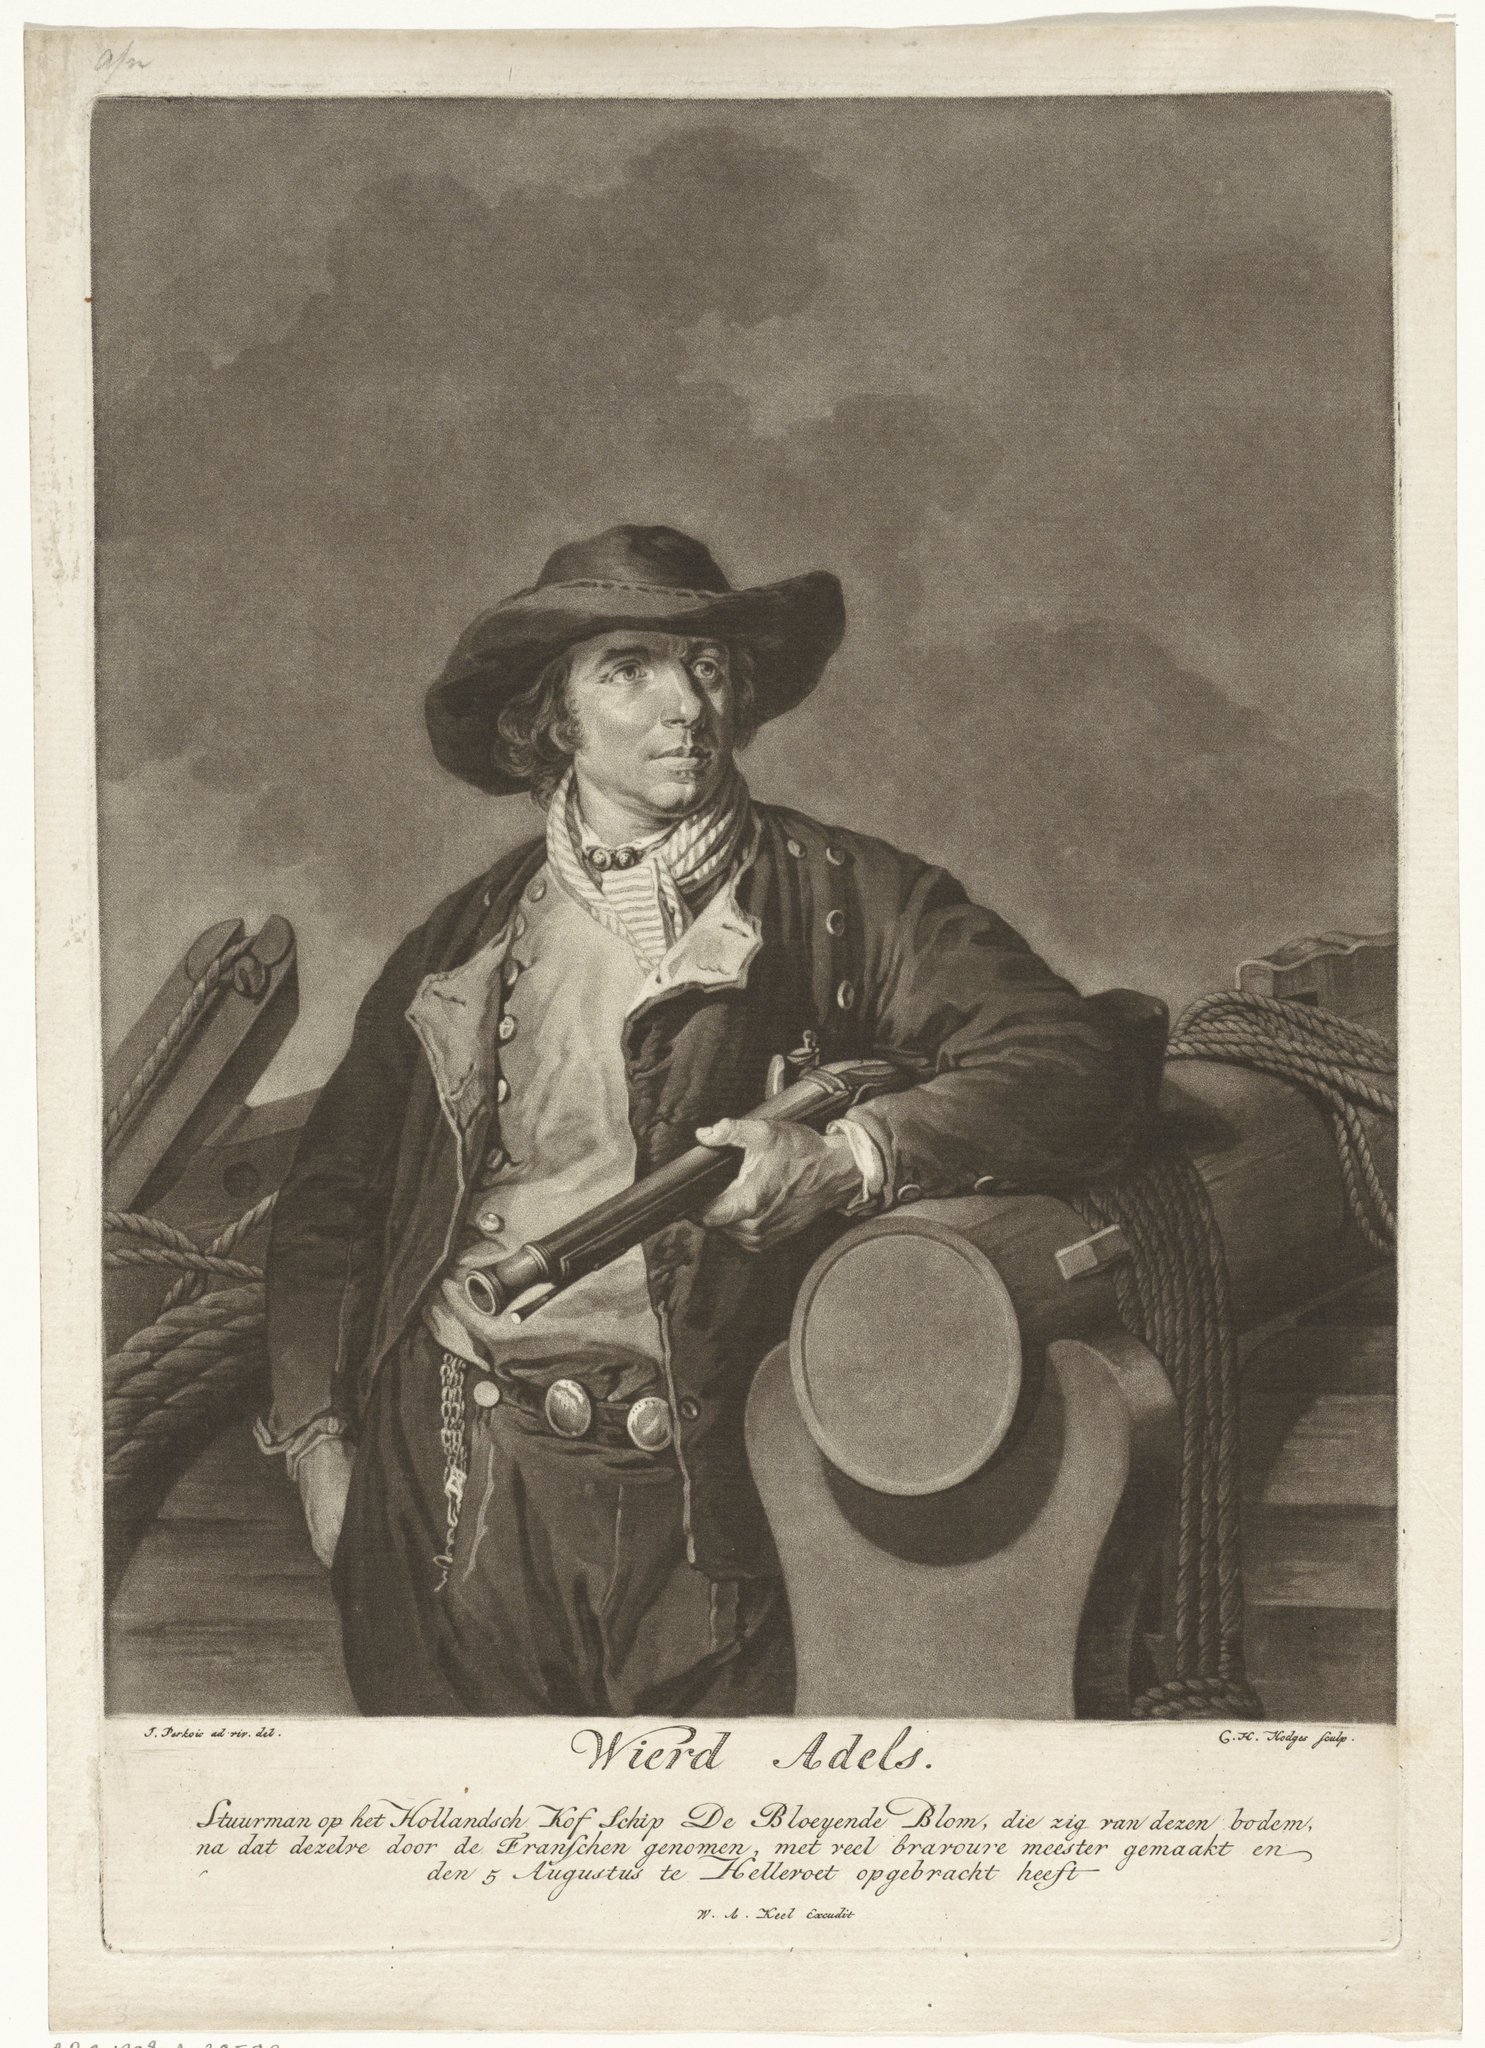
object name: print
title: Portret van Wiert Adels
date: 1794-1796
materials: paper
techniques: engraving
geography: middelburg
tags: firearms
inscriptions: collector's mark: Lugt 964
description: Wiert Adels, stuurman op het kofschip 'De Bloeyende Blom'. Hij draagt zeemanskleding en houdt een geweer in de hand. Zijn arm rust op een stuk geschut. De Bloeyende Blom werd in augustus 1794 door de Fransen gekaapt. Adels heroverde het schip en bracht het op 5 augustus binnen te Hellevoetsluis.